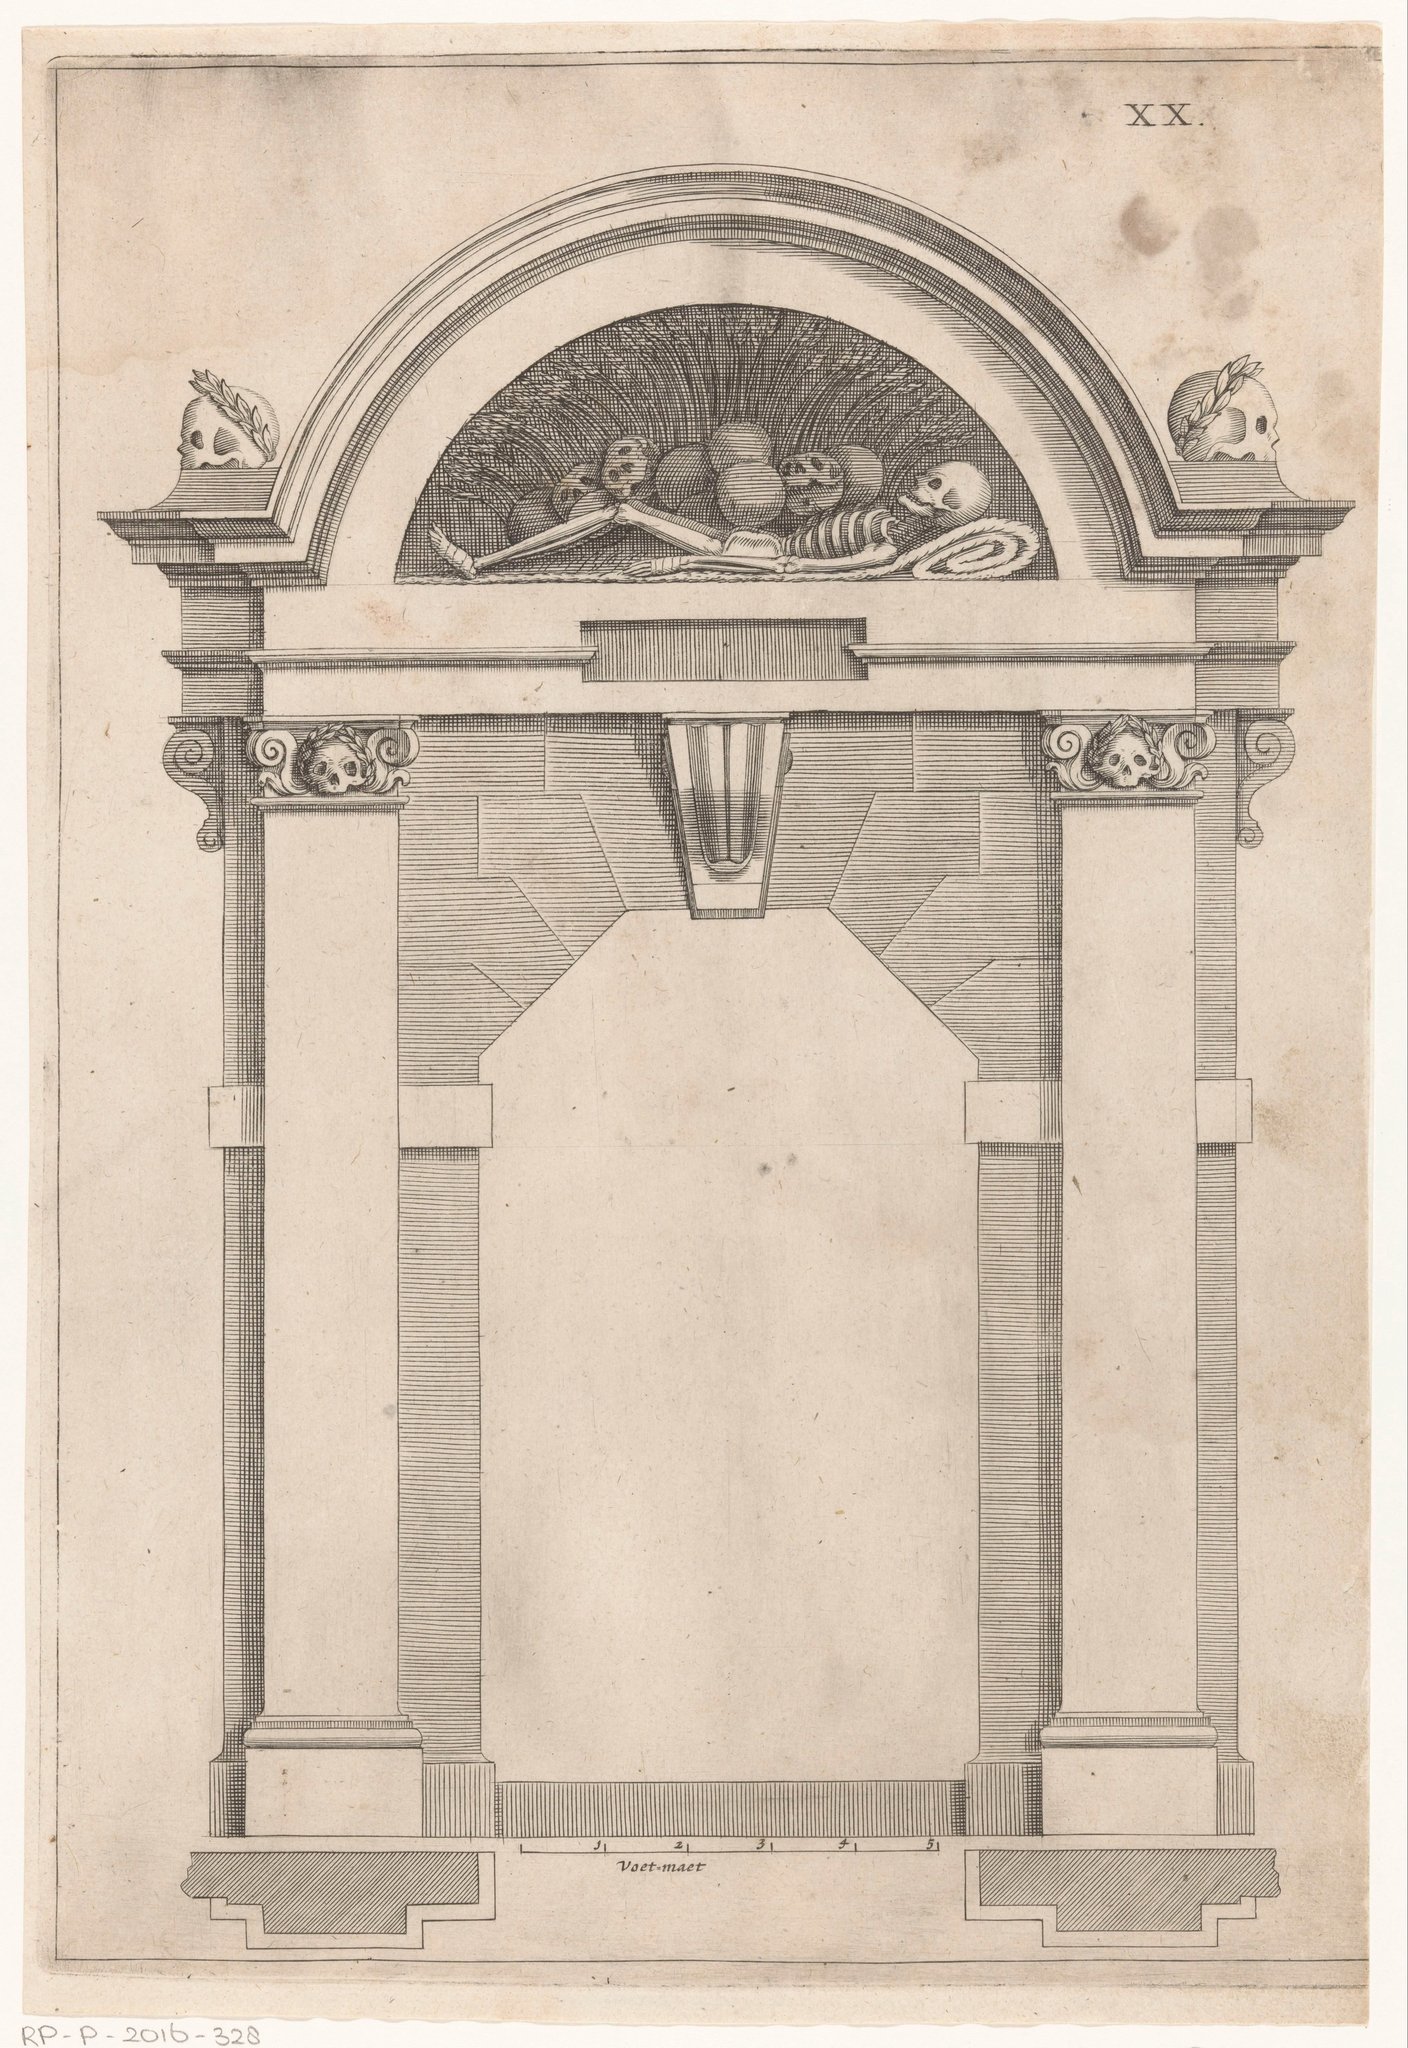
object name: print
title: Poort tot begraafplaats bij de Westerkerk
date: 1631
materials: paper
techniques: engraving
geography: amsterdam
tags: churchyard, cemetery, plan ~ architecture, exterior ~ architectural design or model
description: Prent uit: Keyser, Hendrick de. Architectura moderna ofte bouwinge van onsen tyt (...) alle gedaen by (...) Amsterdam: Danckerts, Cornelis, 1631.